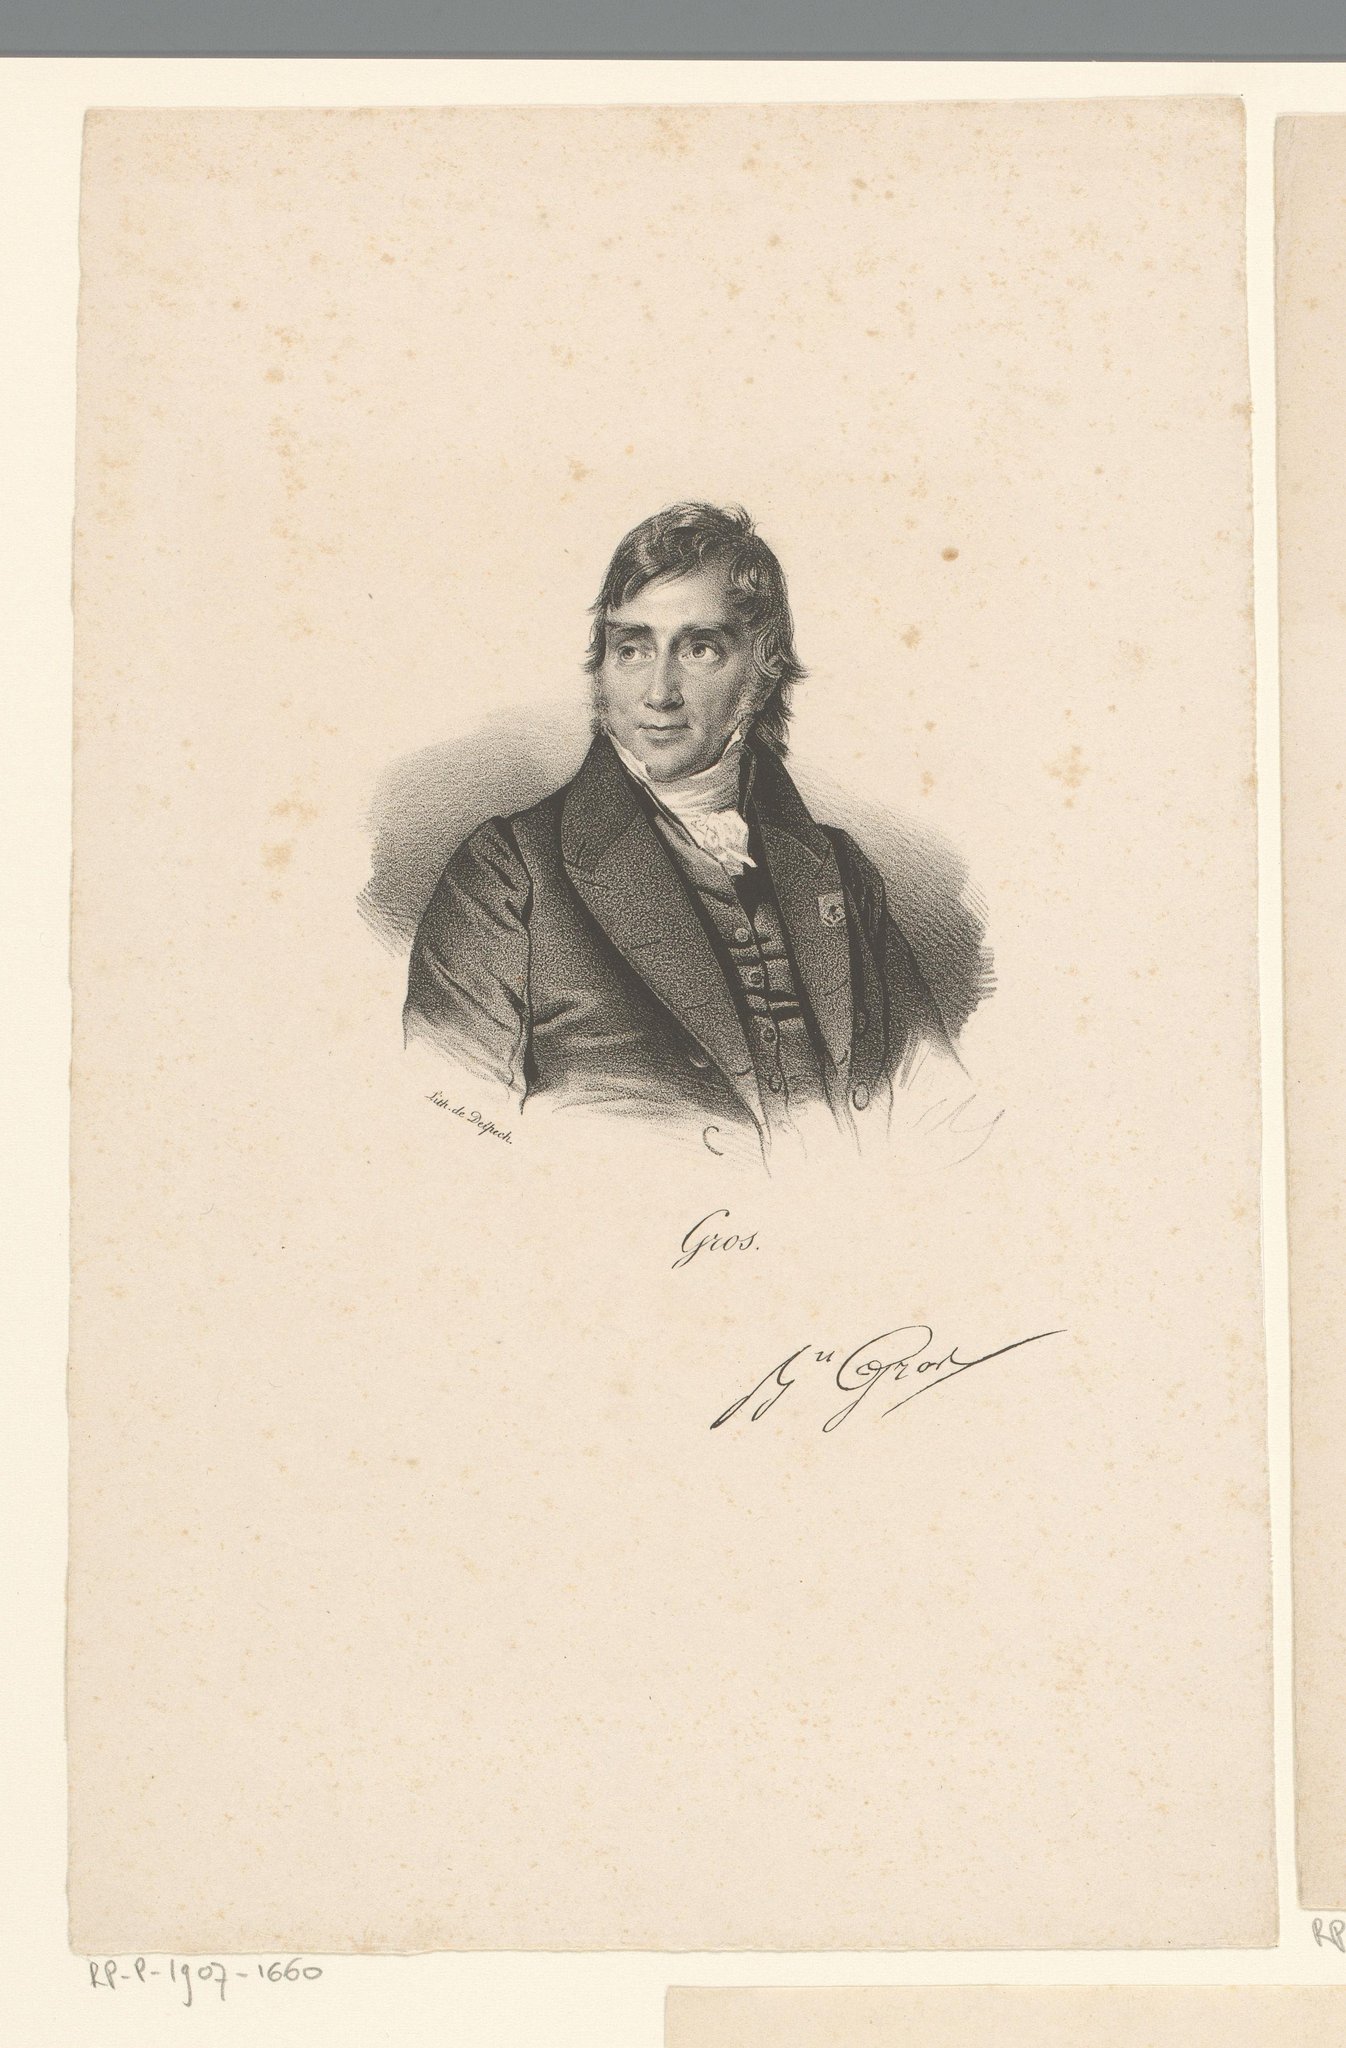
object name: print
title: Portret van Antoine-Jean Gros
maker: nicolas maurin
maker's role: painter, print maker, printer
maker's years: 1798-1850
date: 1818-1842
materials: paper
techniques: lithograph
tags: paris, painter, antoine-jean gros, historical persons, portrait, self-portrait of painter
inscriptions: collector's mark: Lugt 2228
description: Prent waarschijnlijk gebruikt voor: Iconographie des contemporains ou Portraits des personnes dont les noms se rattachent plus particulièrement, soit par leurs actions, soit par leurs écrits, aux divers événements qui ont eu lieu en France, depuis 1789, jusqu'en 1829 (…). Parijs: veuve Delpech, 1832-1833. Mogelijk komt de prent ook voor in eerdere en/of latere publicaties uitgegeven door veuve Delpech of haar opvolger Rosselin.